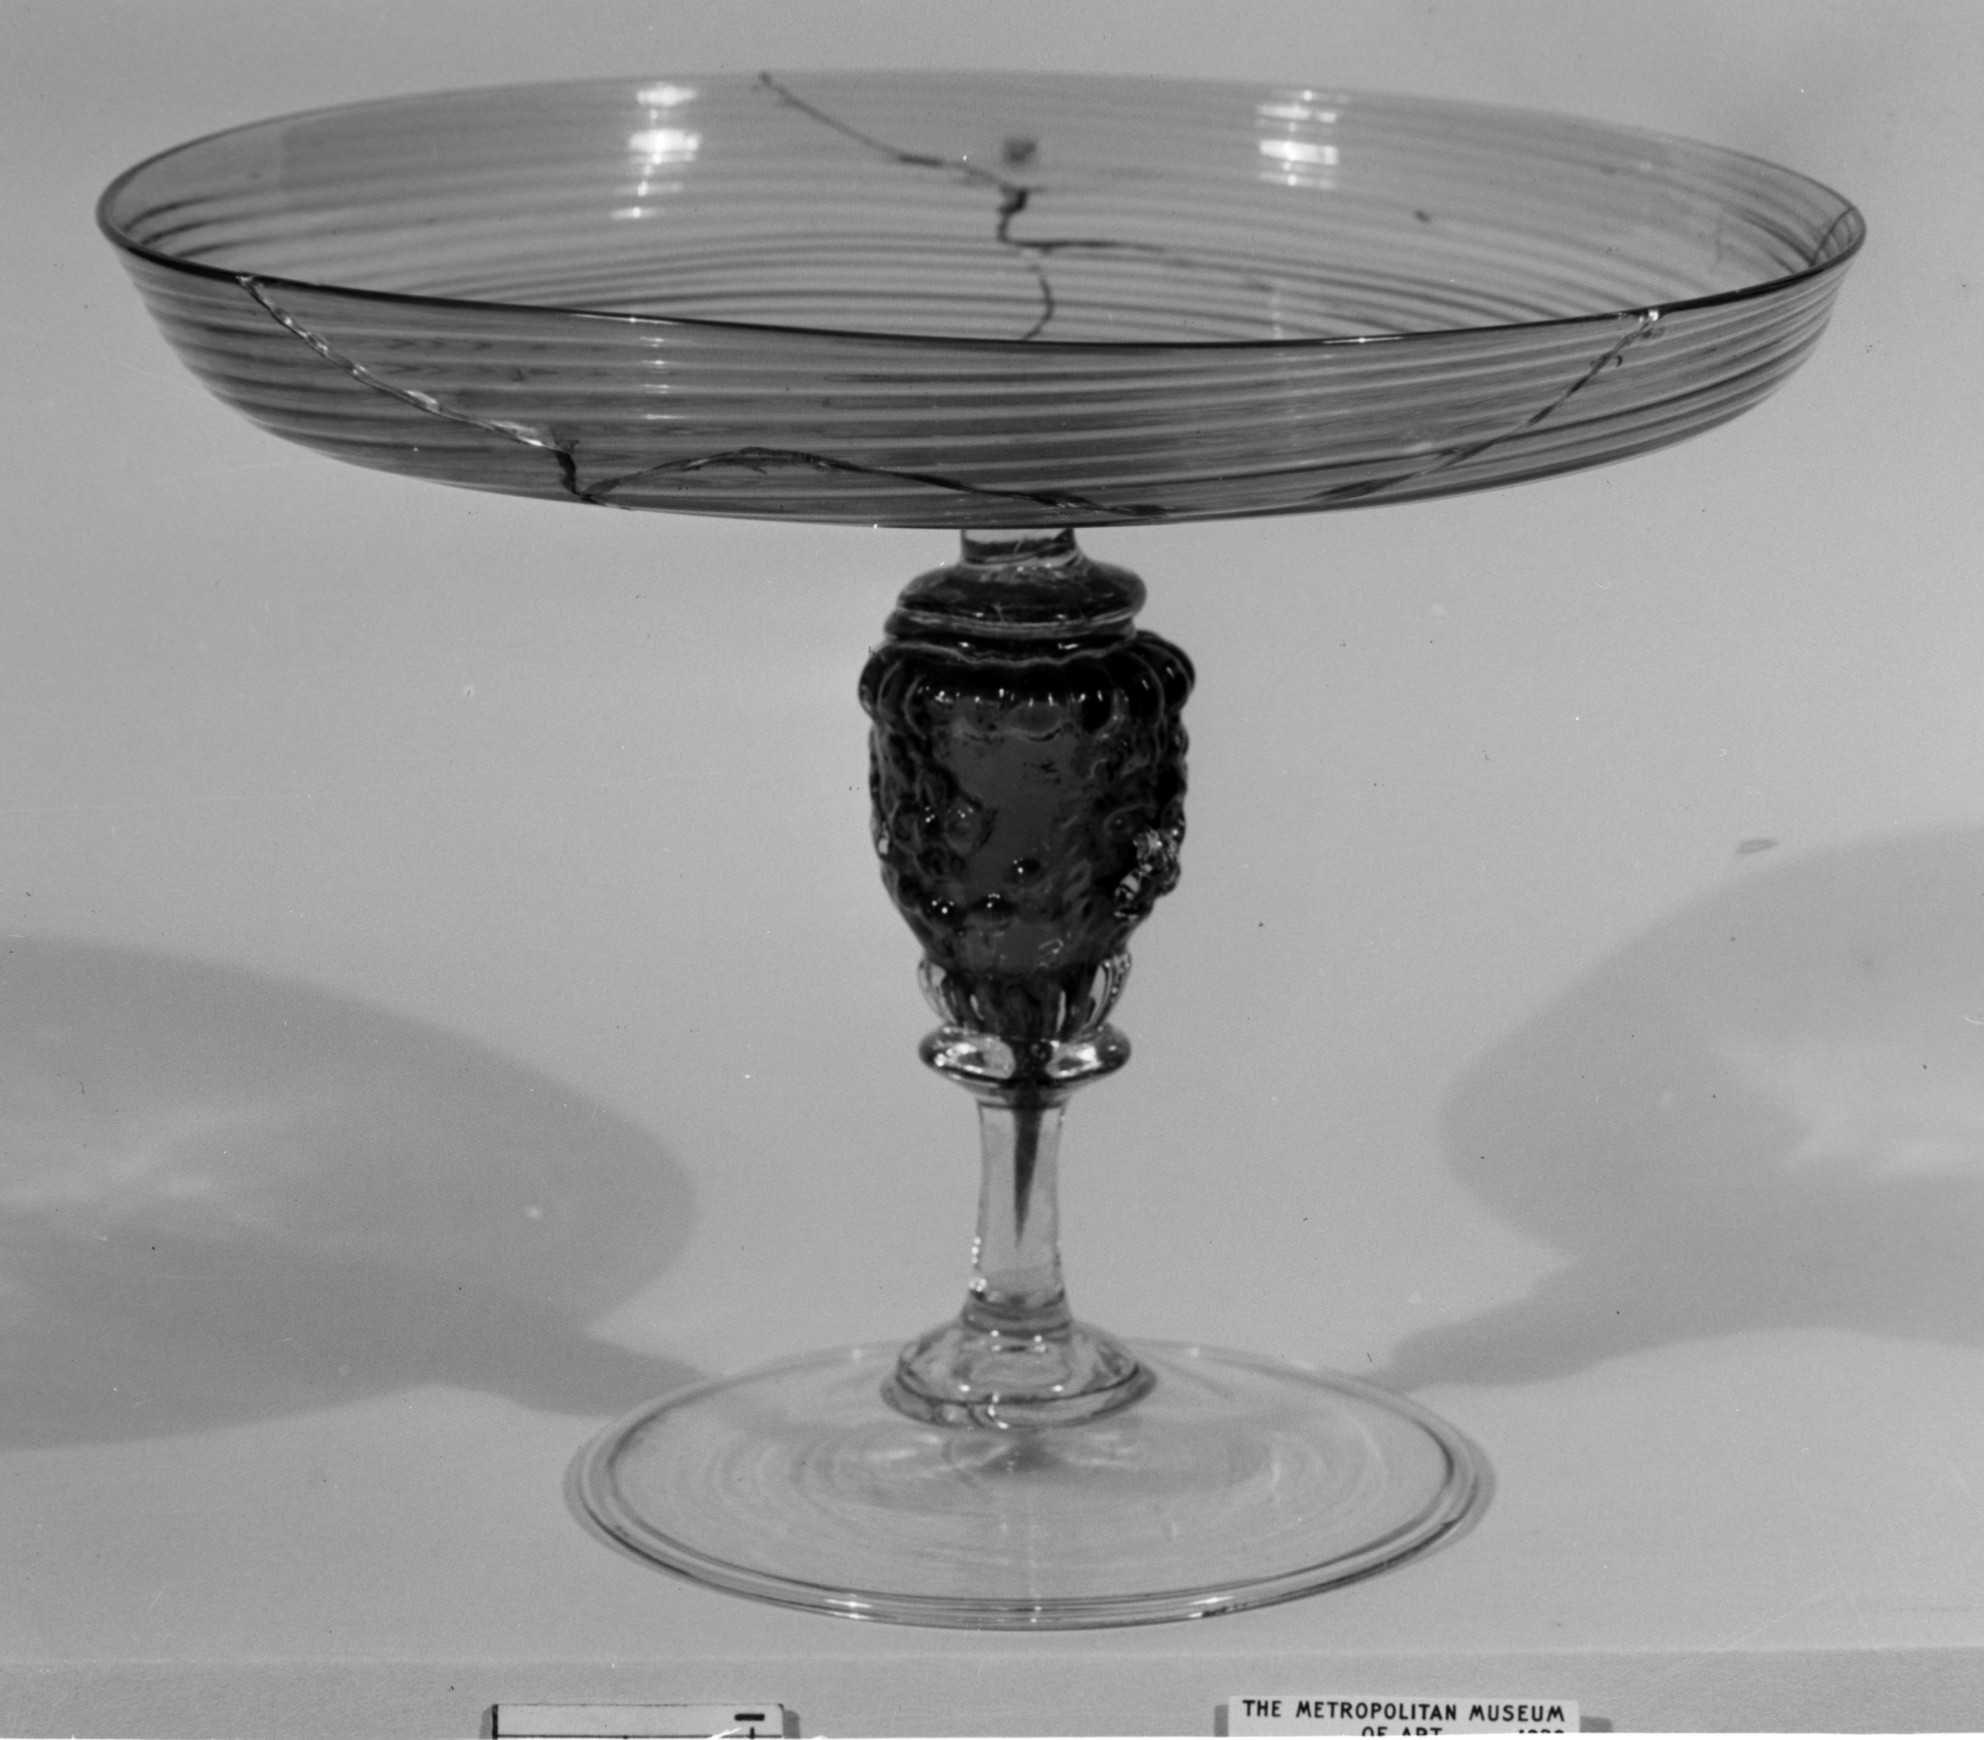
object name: tazza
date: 1567-1600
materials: glass